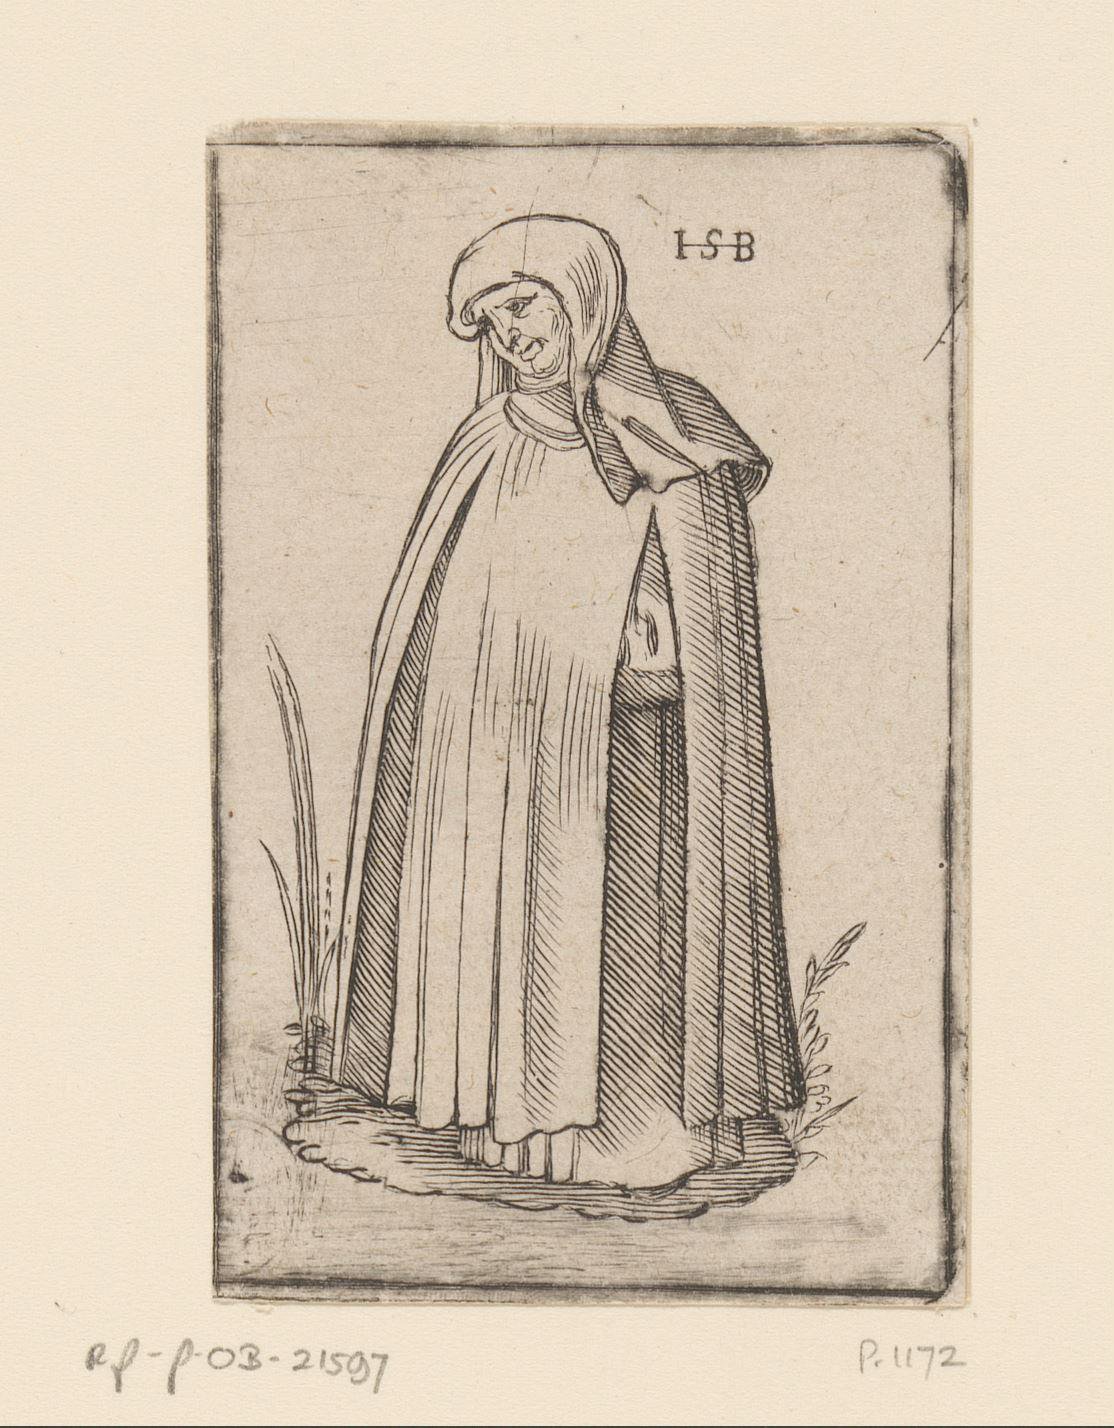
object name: print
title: Kostuums van geestelijken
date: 1526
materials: paper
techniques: engraving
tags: liturgical vestments, canonicals, monastic orders, monastic life ~ roman catholic church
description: Onderdeel van een serie van 28 gegraveerde kopieën in de andere richting naar Hans Sebald Behams "Das Papstthum mit seinen Gliedern", 1526.